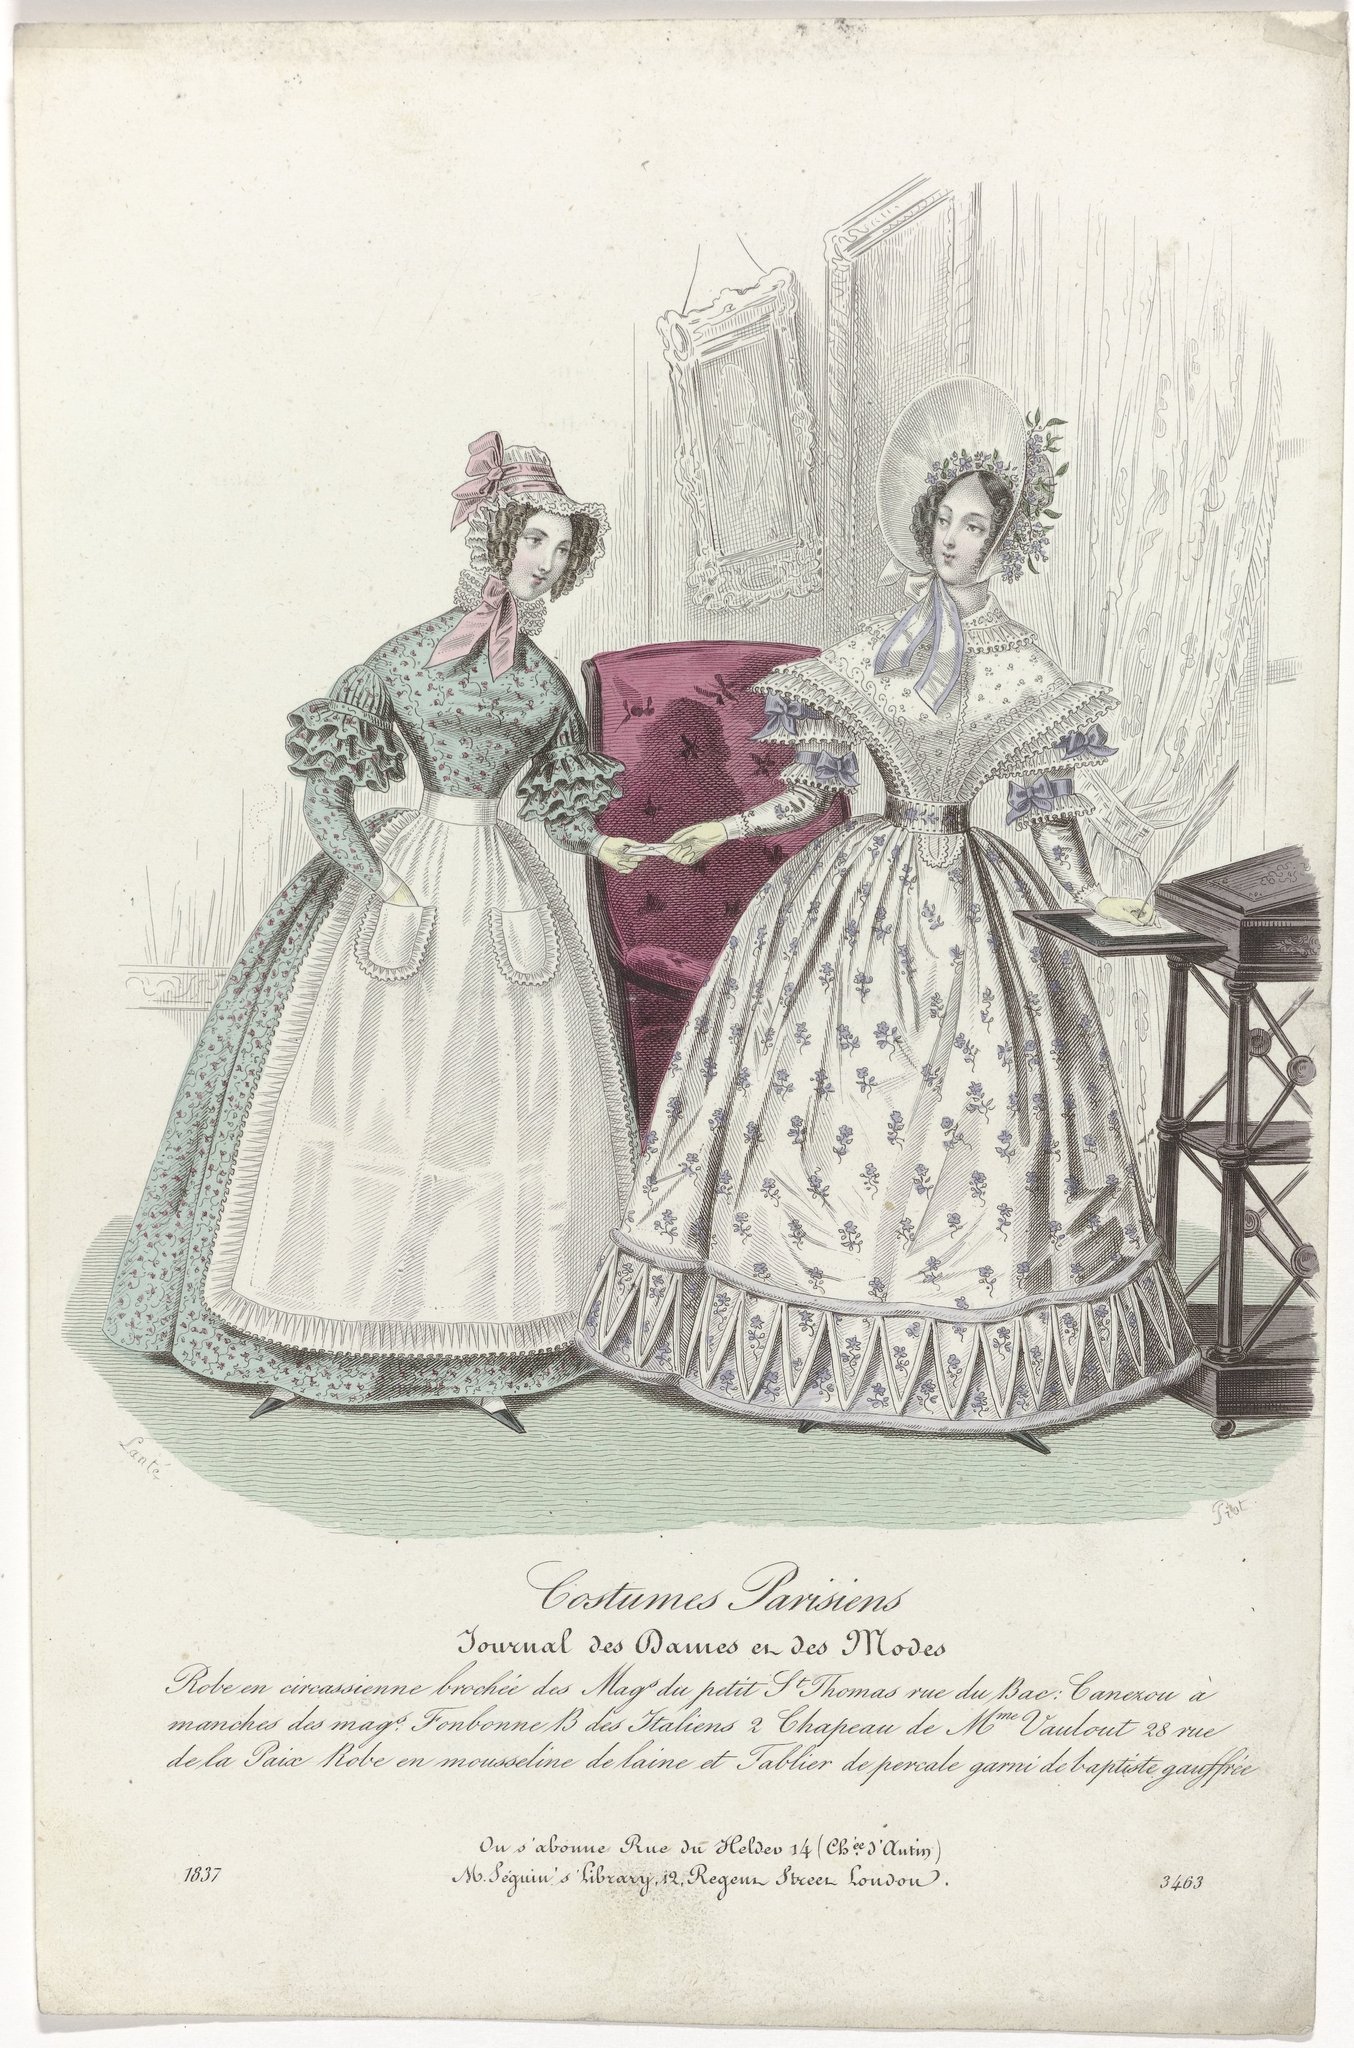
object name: fashion print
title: Journal des Dames et des Modes, Costumes Parisiens, 1837, (3463): Robe en circassienn (...)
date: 1837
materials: paper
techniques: engraving, hand coloring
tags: quill, clothing for the upper part of the body: blouse (+ women's clothes), dress, gown: robe à la circassienne (+ women's clothes), head-gear: cap (+ women's clothes), fashion plates, head-gear: hat (+ women's clothes), shoes, sandals (+ women's clothes), gloves, mittens, etc. (+ women's clothes), interior of the house, letter, envelope, apron (+ women's clothes), neck-gear ~ clothing (+ women's clothes)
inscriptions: address: ‘On s'abonne Rue du Helder 14 (Ch.ée d'Antin) / M. Séguin 's Library, 12, Regent Street London.’, caption: ‘Robe en circassienne brochée des Mags du petit St Thomas rue du Bac: Canezou à manches des mag.s Fonbonne B des Italiens 2 Chapeau de Mme Vaulout 28 rue de la Paix Robe en mousseline de laine et Tablier de percale garni de baptiste gauffrée’, title: ‘Costumes Parisiens / Journal des Dames et des Modes’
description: Vrouw gekleed in een 'robe en circassienne', uit de winkels van petit St Thomas. 'Canezou' met mouwen uit de winkels van Fonbonne B. Op het hoofd een luifelhoed van Vaulout. Schrijfveer in de hand. Zij geeft een brief aan een vrouw gekleed in een japon van wollen mousseline met een schort van 'percale'. Op het hoofd een muts. De prent maakt deel uit van het modetijdschrift Journal des Dames et des Modes, Parijs, 1797-1839.